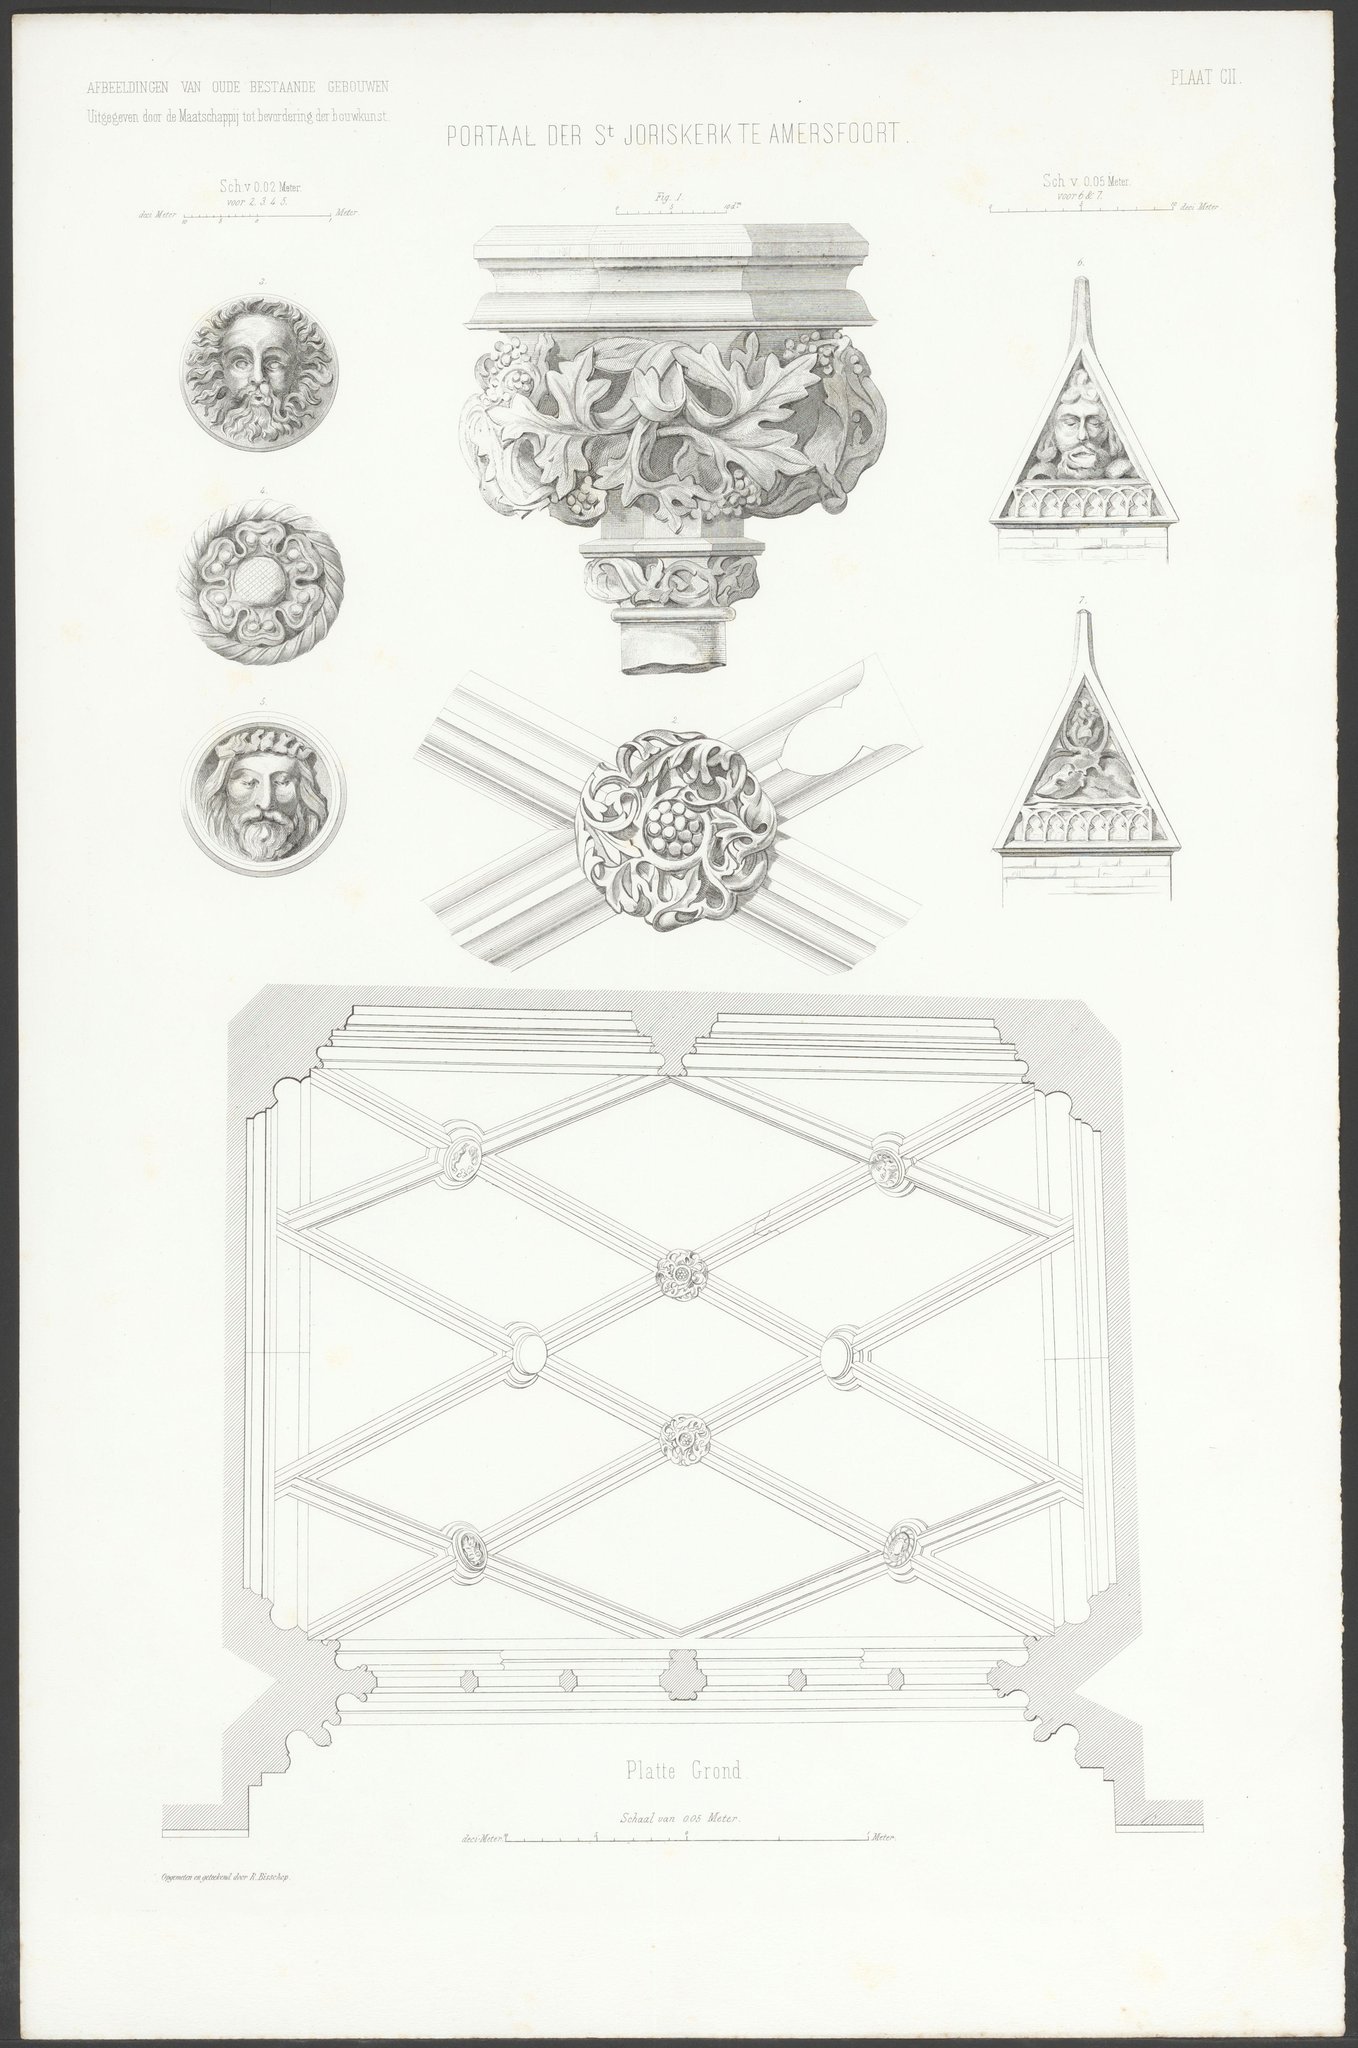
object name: print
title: Portaal der St. Joriskerk te Amersfoort / Afbeeldingen van oude bestaande gebouwen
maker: richard bisschop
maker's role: draughtsman, painter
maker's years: 1849-1926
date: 1865-1907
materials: paper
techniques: lithograph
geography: amsterdam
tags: parts of church exterior and annexes: portal, architectural detail, church (exterior), plan ~ architecture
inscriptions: collector's mark: Lugt 1641, collector's mark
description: Details en plattegrond van het portaal van de Sint-Joriskerk te Amersfoort. Onderaan een schaalstok. Architectuurvoorstelling. Plaat CII. Onderwerpsrubrieken binnen de Atlas Zeden en Gewoonten: Kerk en kerkwezen & Armwezen en liefdadige instellingen; Kerkgebouwen elders. A-E.